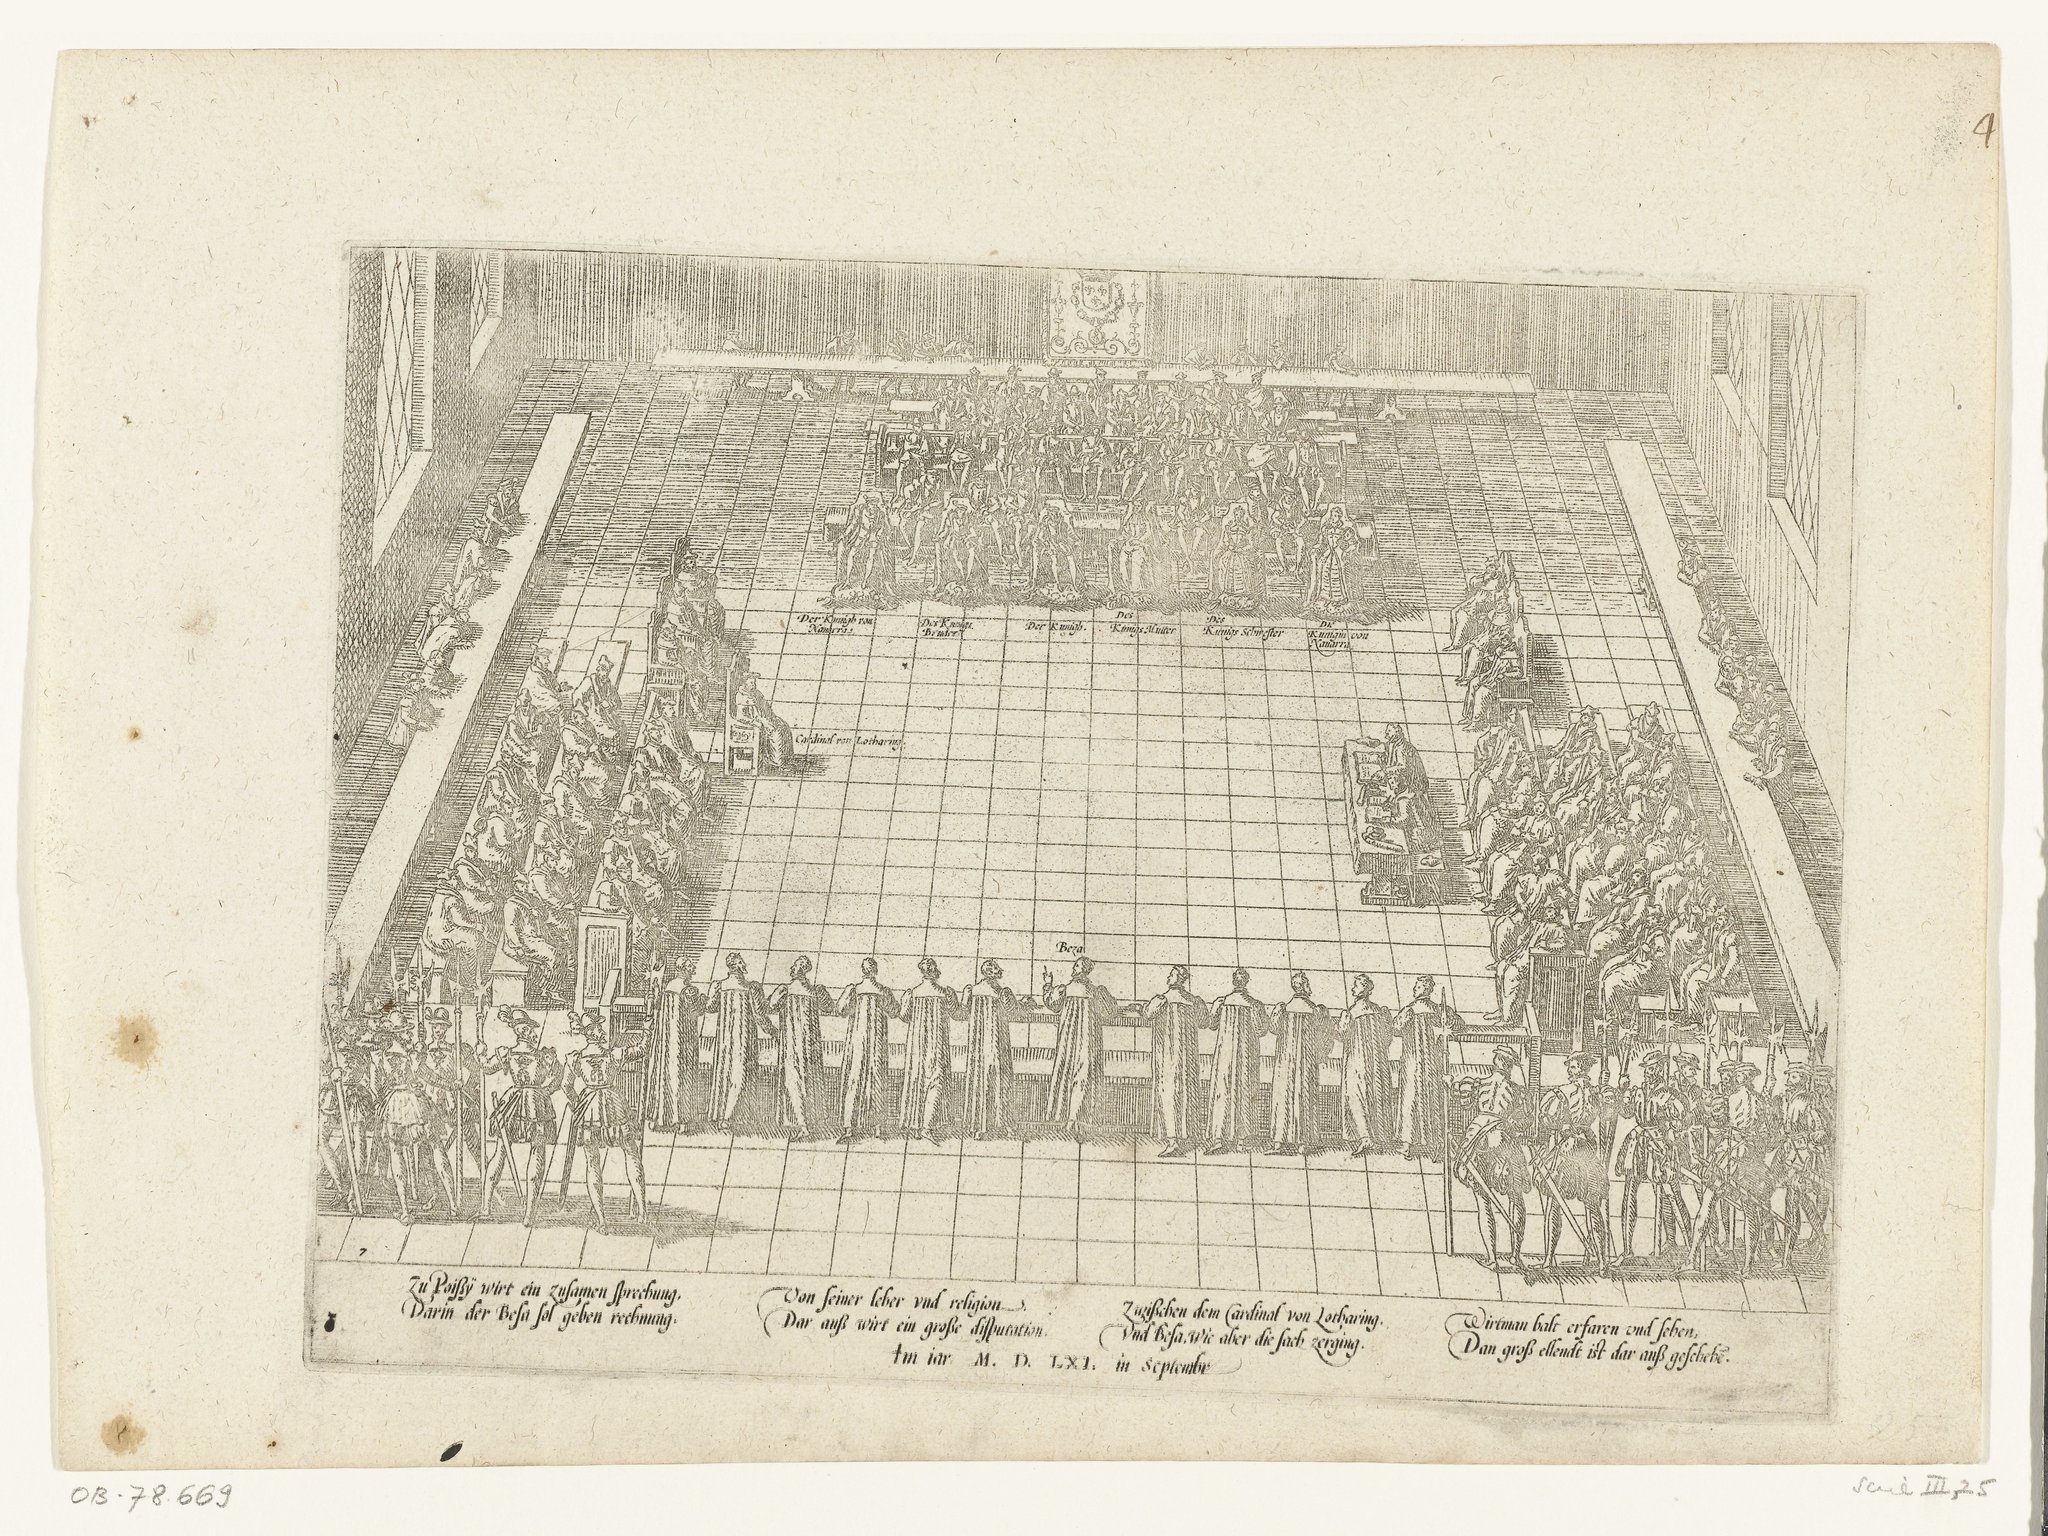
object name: print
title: Serie 3: Franse Godsdienstoorlogen, 1559-1573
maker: frans hogenberg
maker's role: print maker, publisher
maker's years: 1538-1590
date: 1565-1573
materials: paper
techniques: etching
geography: cologne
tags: theodorus beza, karel ix (koning van frankrijk)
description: Gekopieerd naar de prent in: Jean Tortorel et Jacques Perrissin, Premier volume contenant quarante tableaux ou Histoires diverses qui sont memorables touchant les Guerres, Massacres et Troubles advenus en France en ces dernieres annees : le tout recueilly selon le tesmoignange de ceux qui y ont esté en personne et qui les ont veus : lesquels sont pourtraits à la vérité, Genève ca. 1570. Bibliotheek Rijksmuseum: 329 A 2, pl. 10.